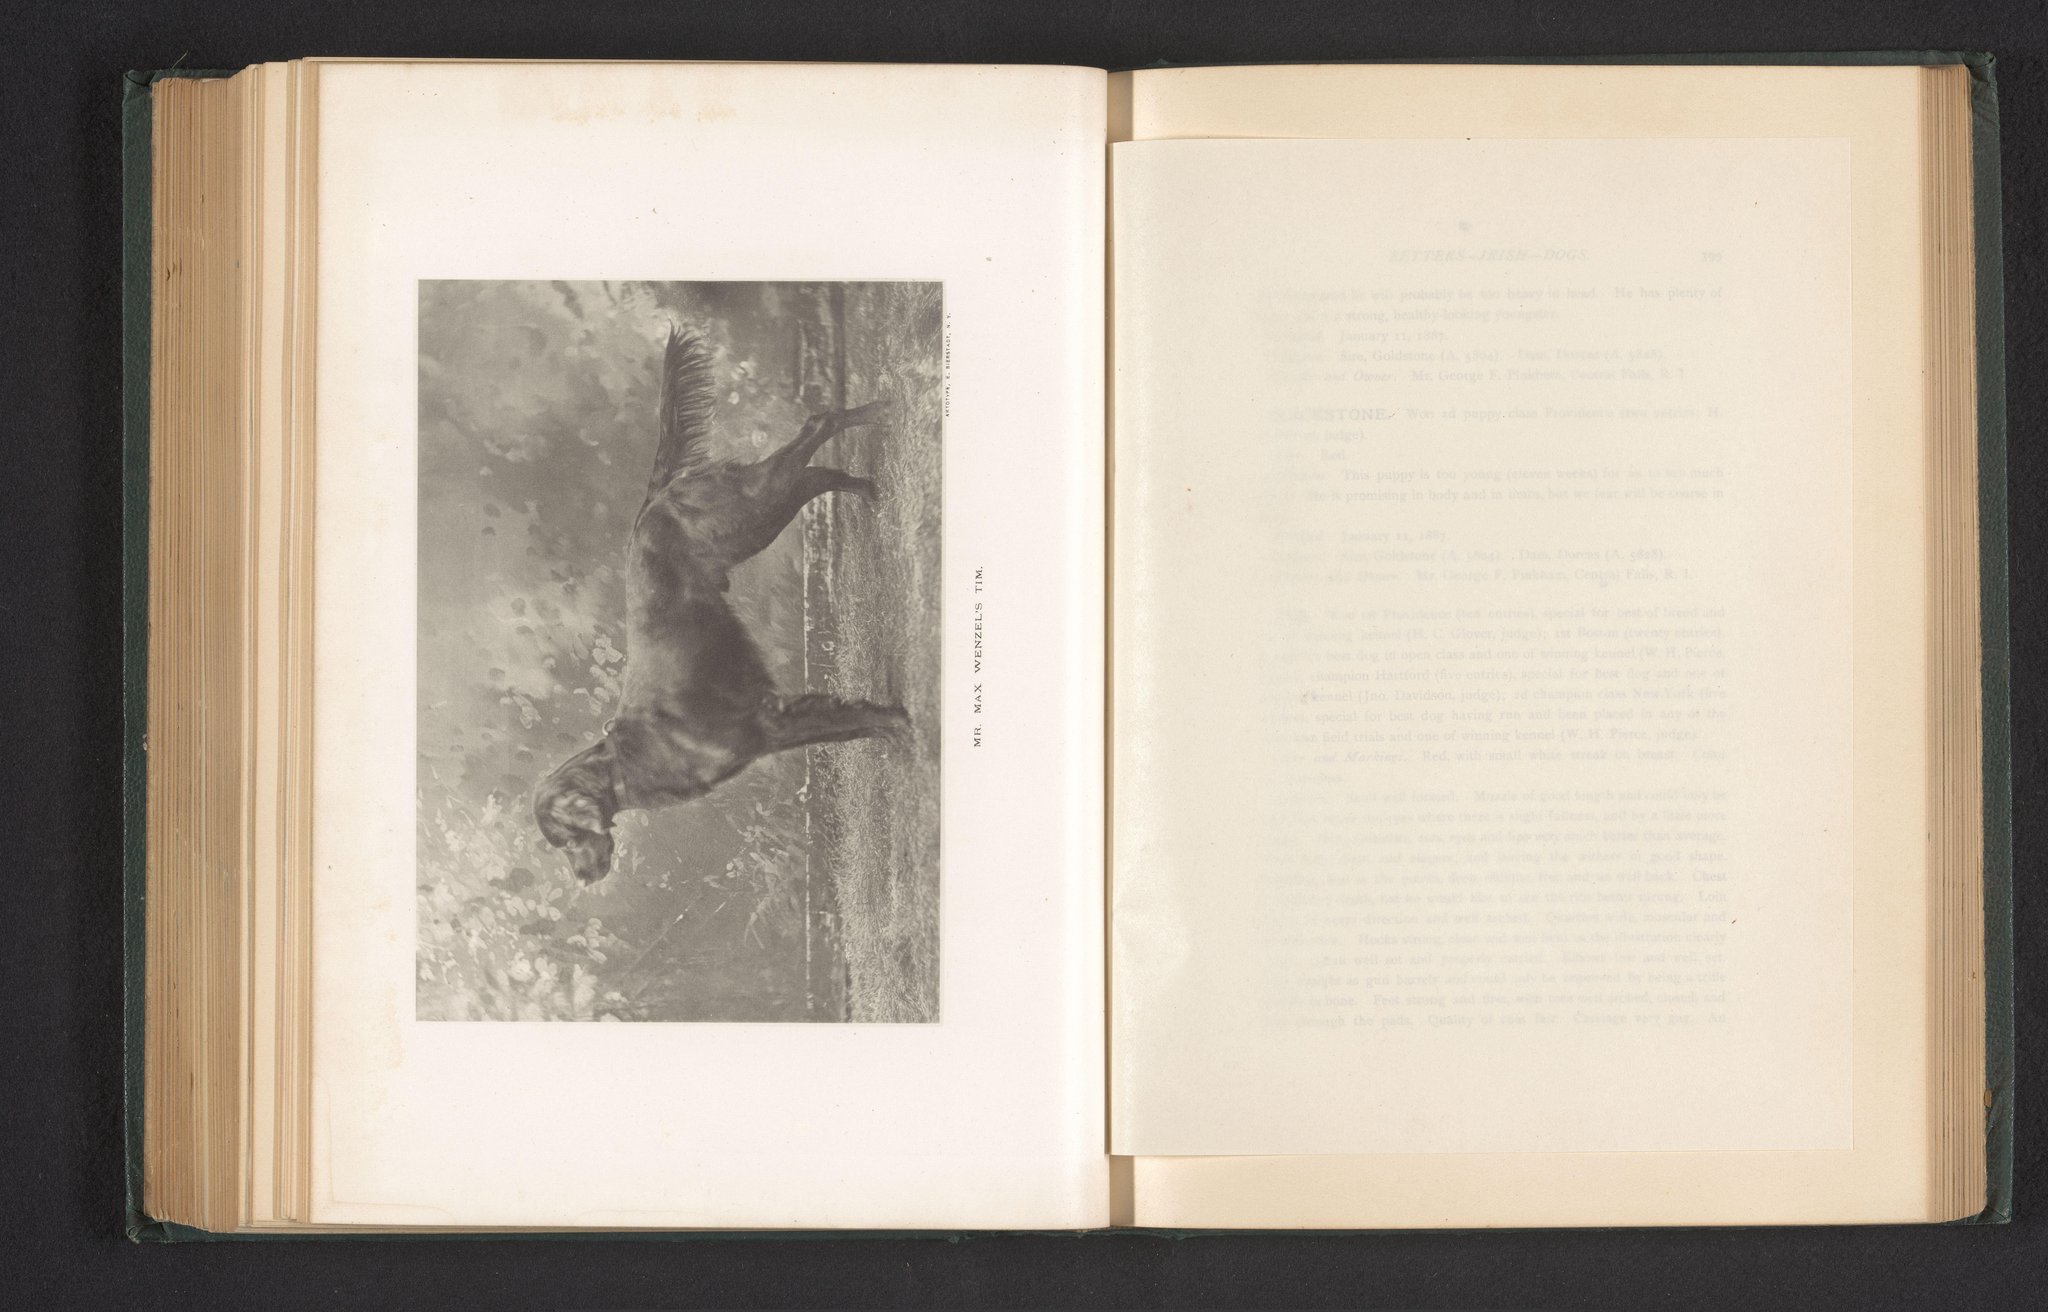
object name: photomechanical print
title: Setter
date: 1883-1888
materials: paper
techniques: photograph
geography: new york city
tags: dog (with name of kind)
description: Prent tegenover pagina 399, achter semi-transparante omslag.